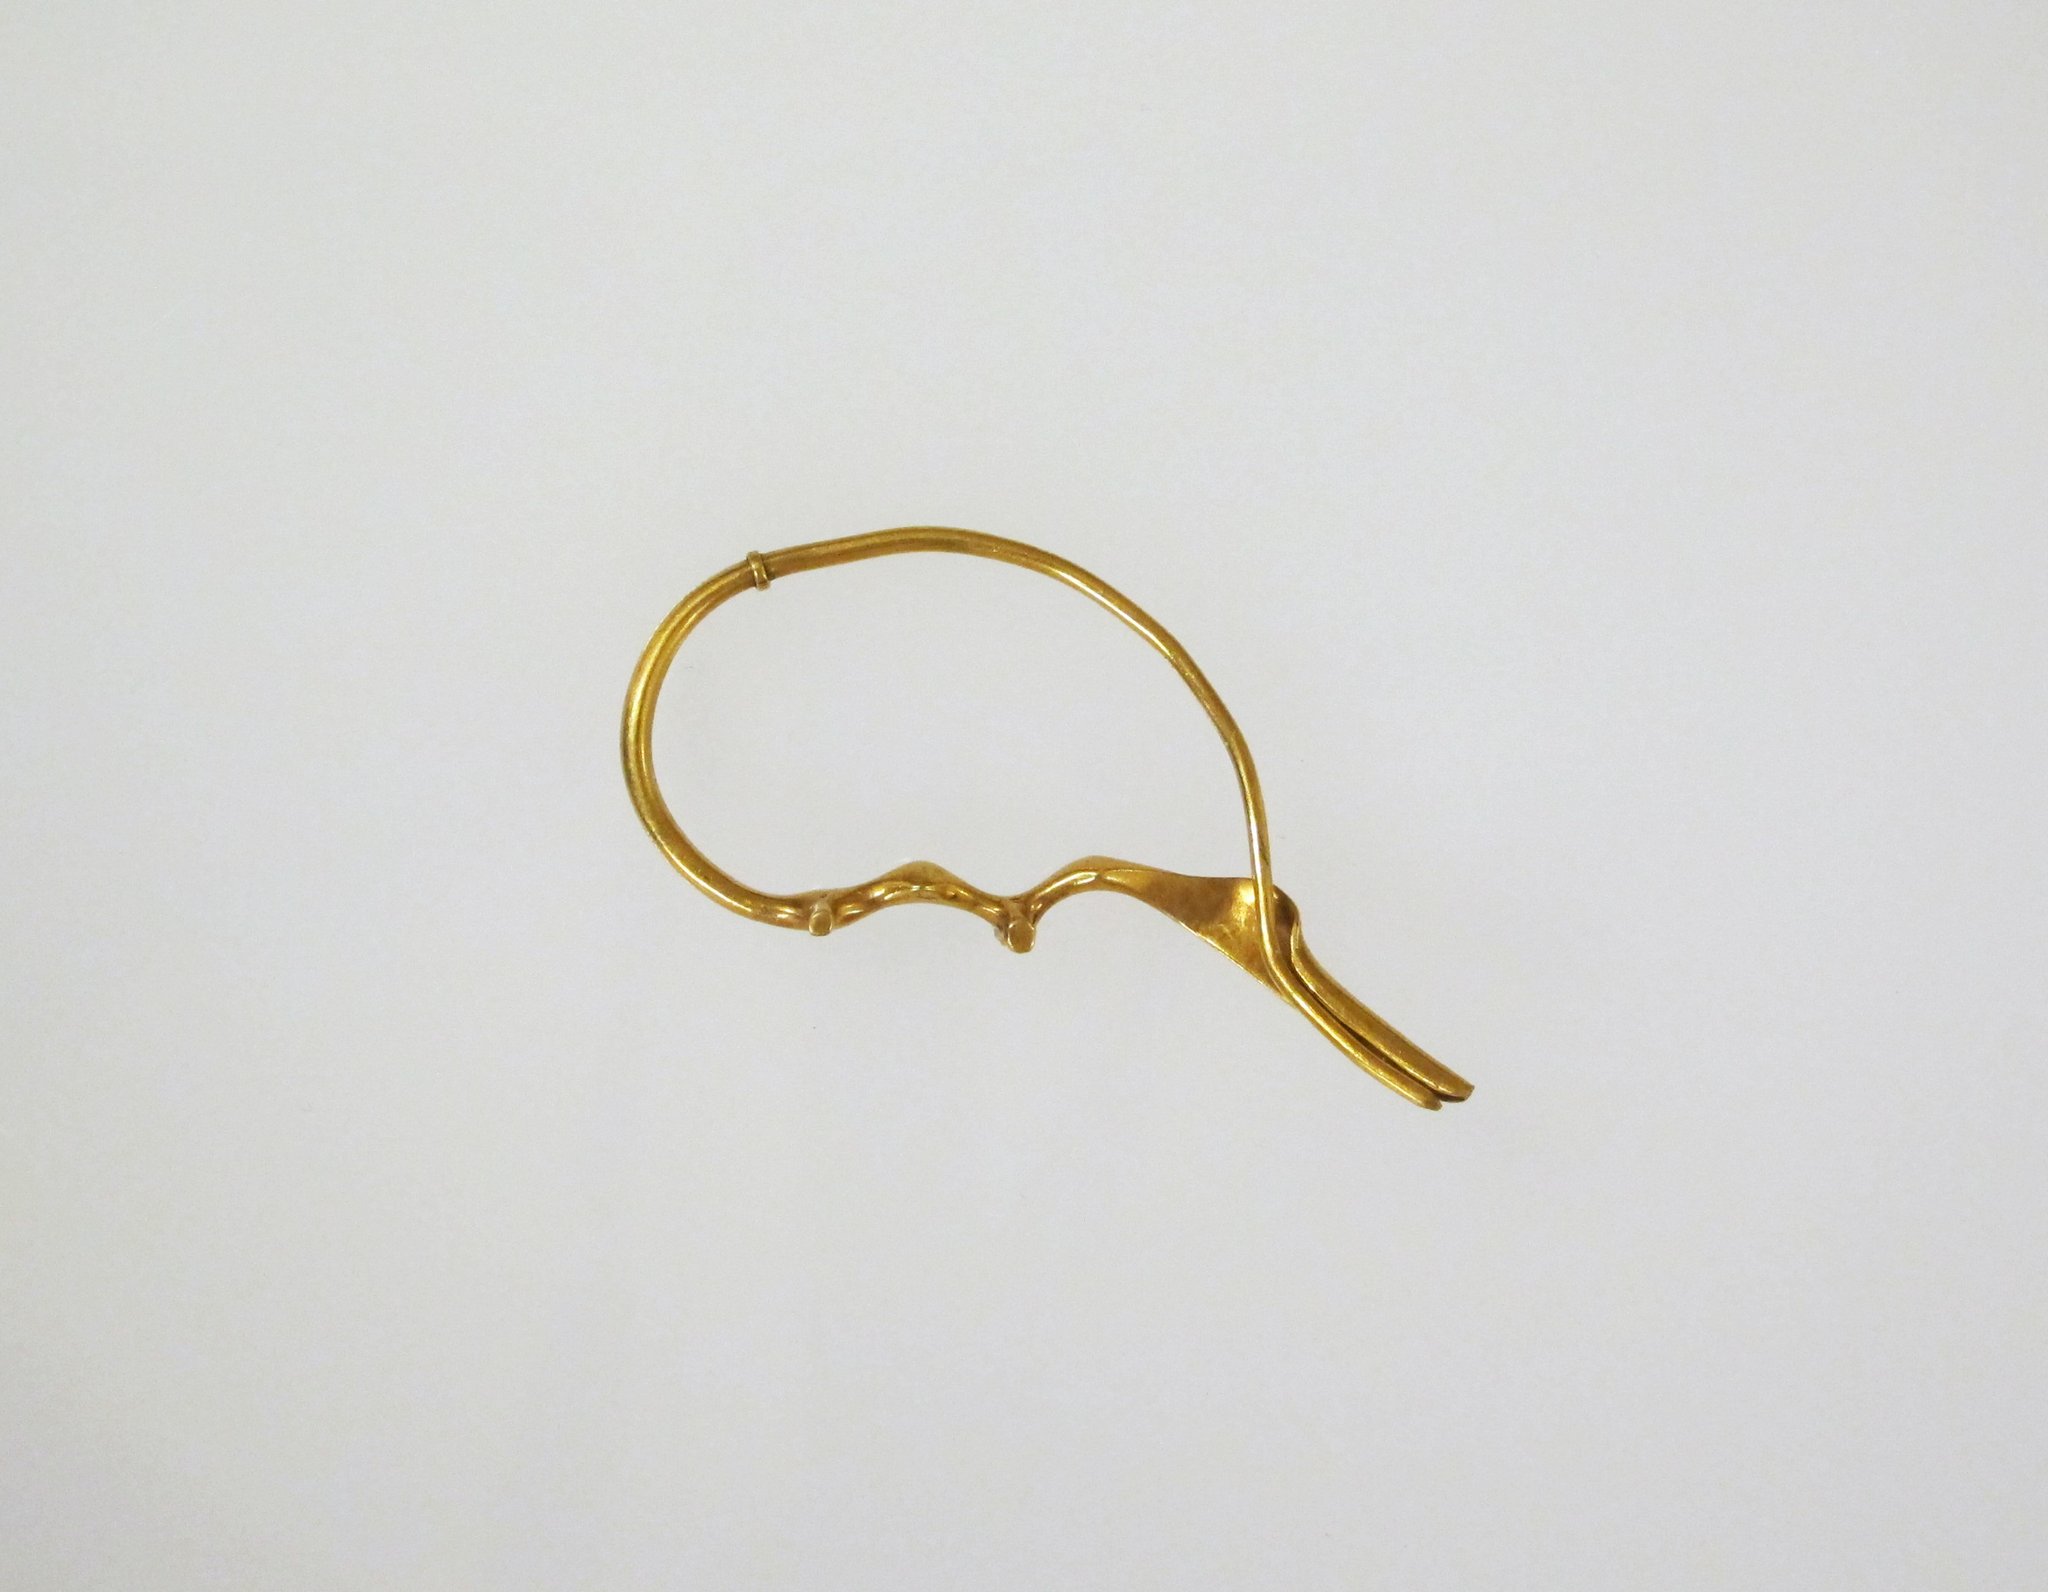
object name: fibula, serpentine type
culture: italic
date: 800-701 BCE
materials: gold